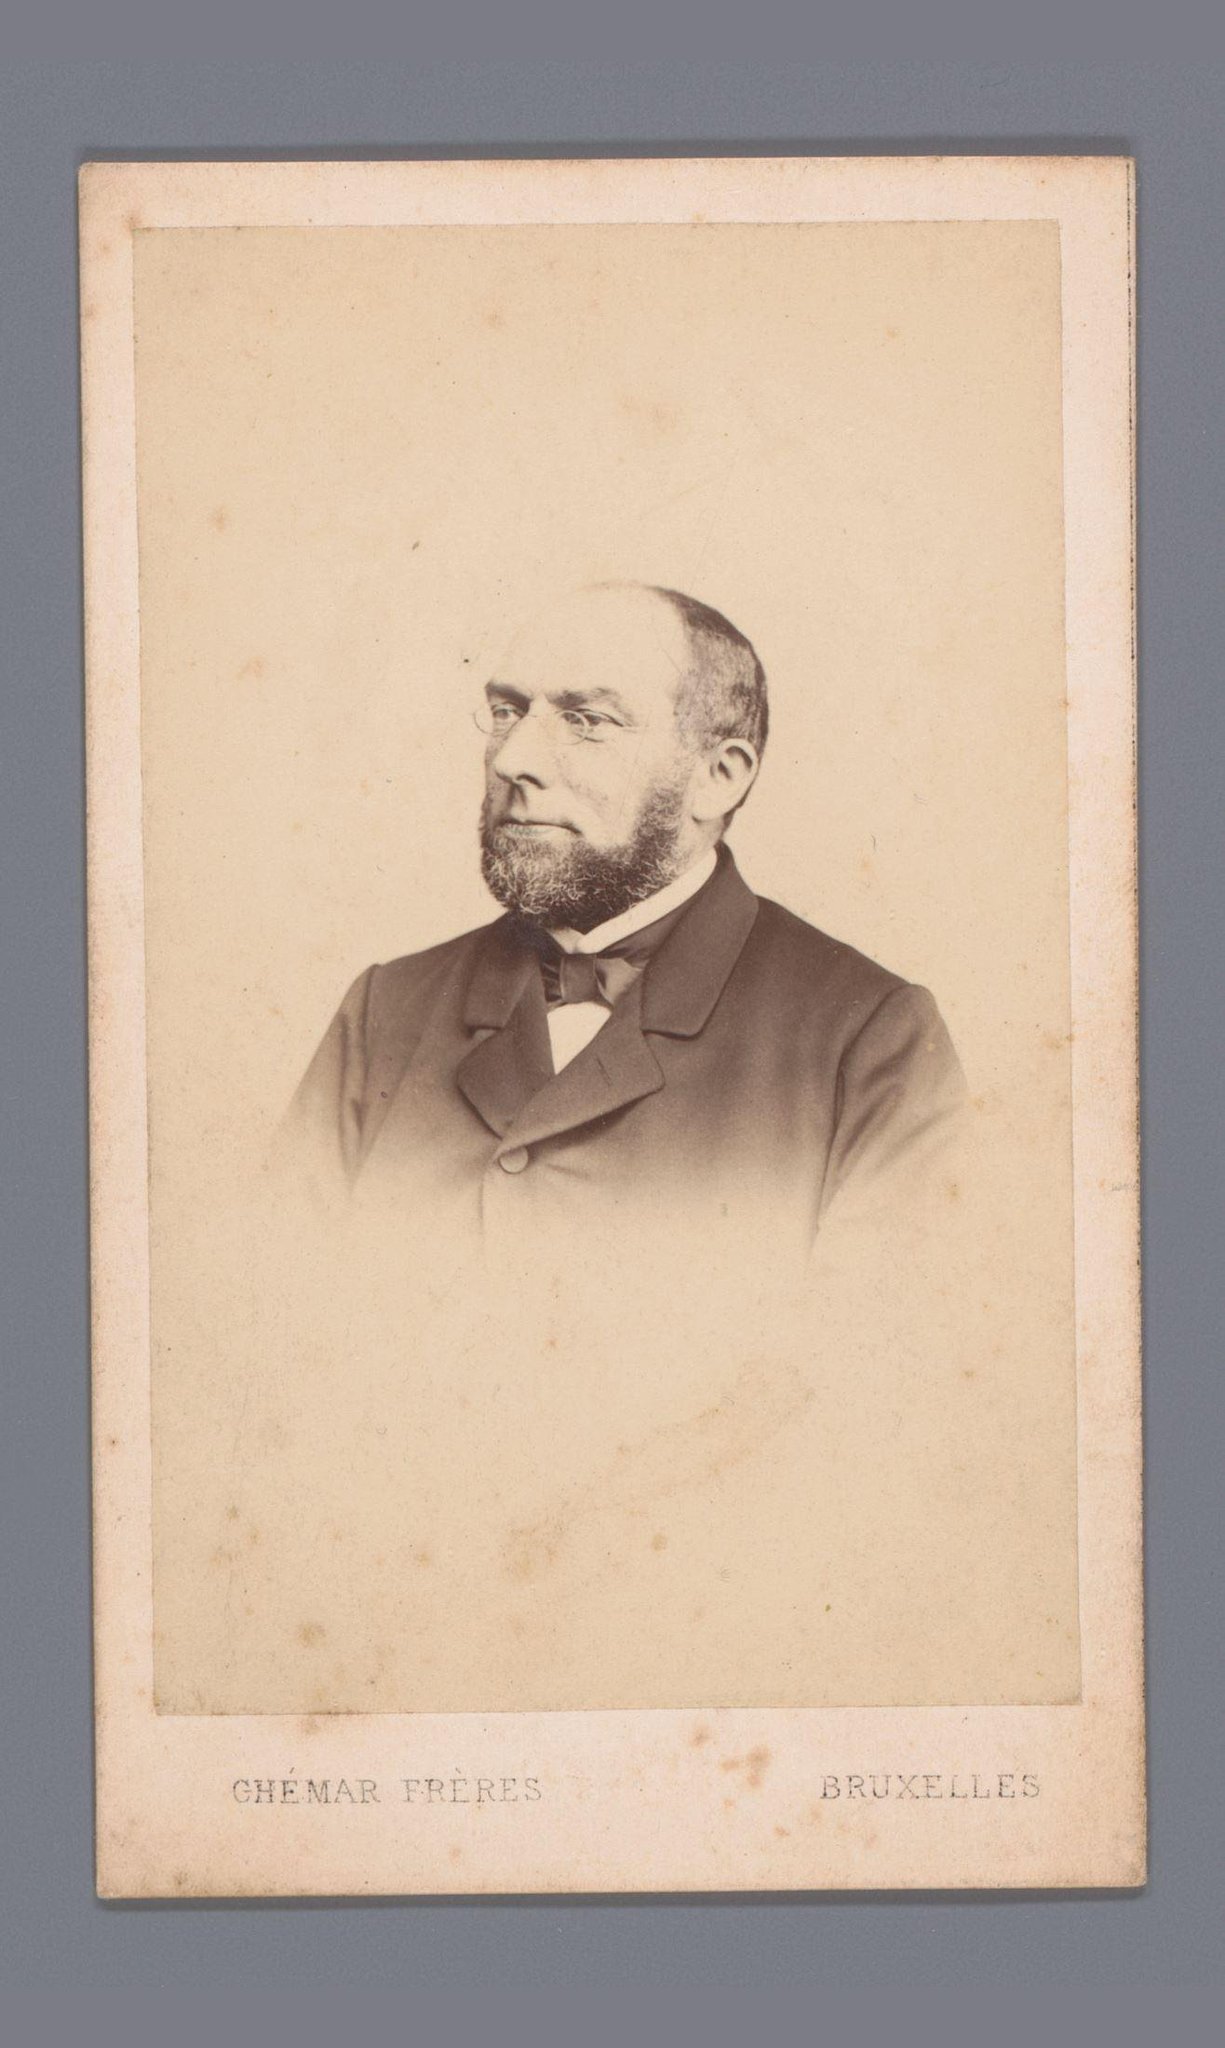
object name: carte de visite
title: Portret van een onbekende man met baard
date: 1859-1885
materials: cardboard, paper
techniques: albumen print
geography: brussels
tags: adult man, anonymous historical person portrayed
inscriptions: inscription: ‘Les Clichés étant conservés indéfiniment/ on peut toujours se procurer de nouvelles/ épreuves de Cartes & Portraits sans reposer’, address: ‘27, Rue de l'Ecuyer, 27,/ Entrée par la porte cochère/ BRUXELLES’